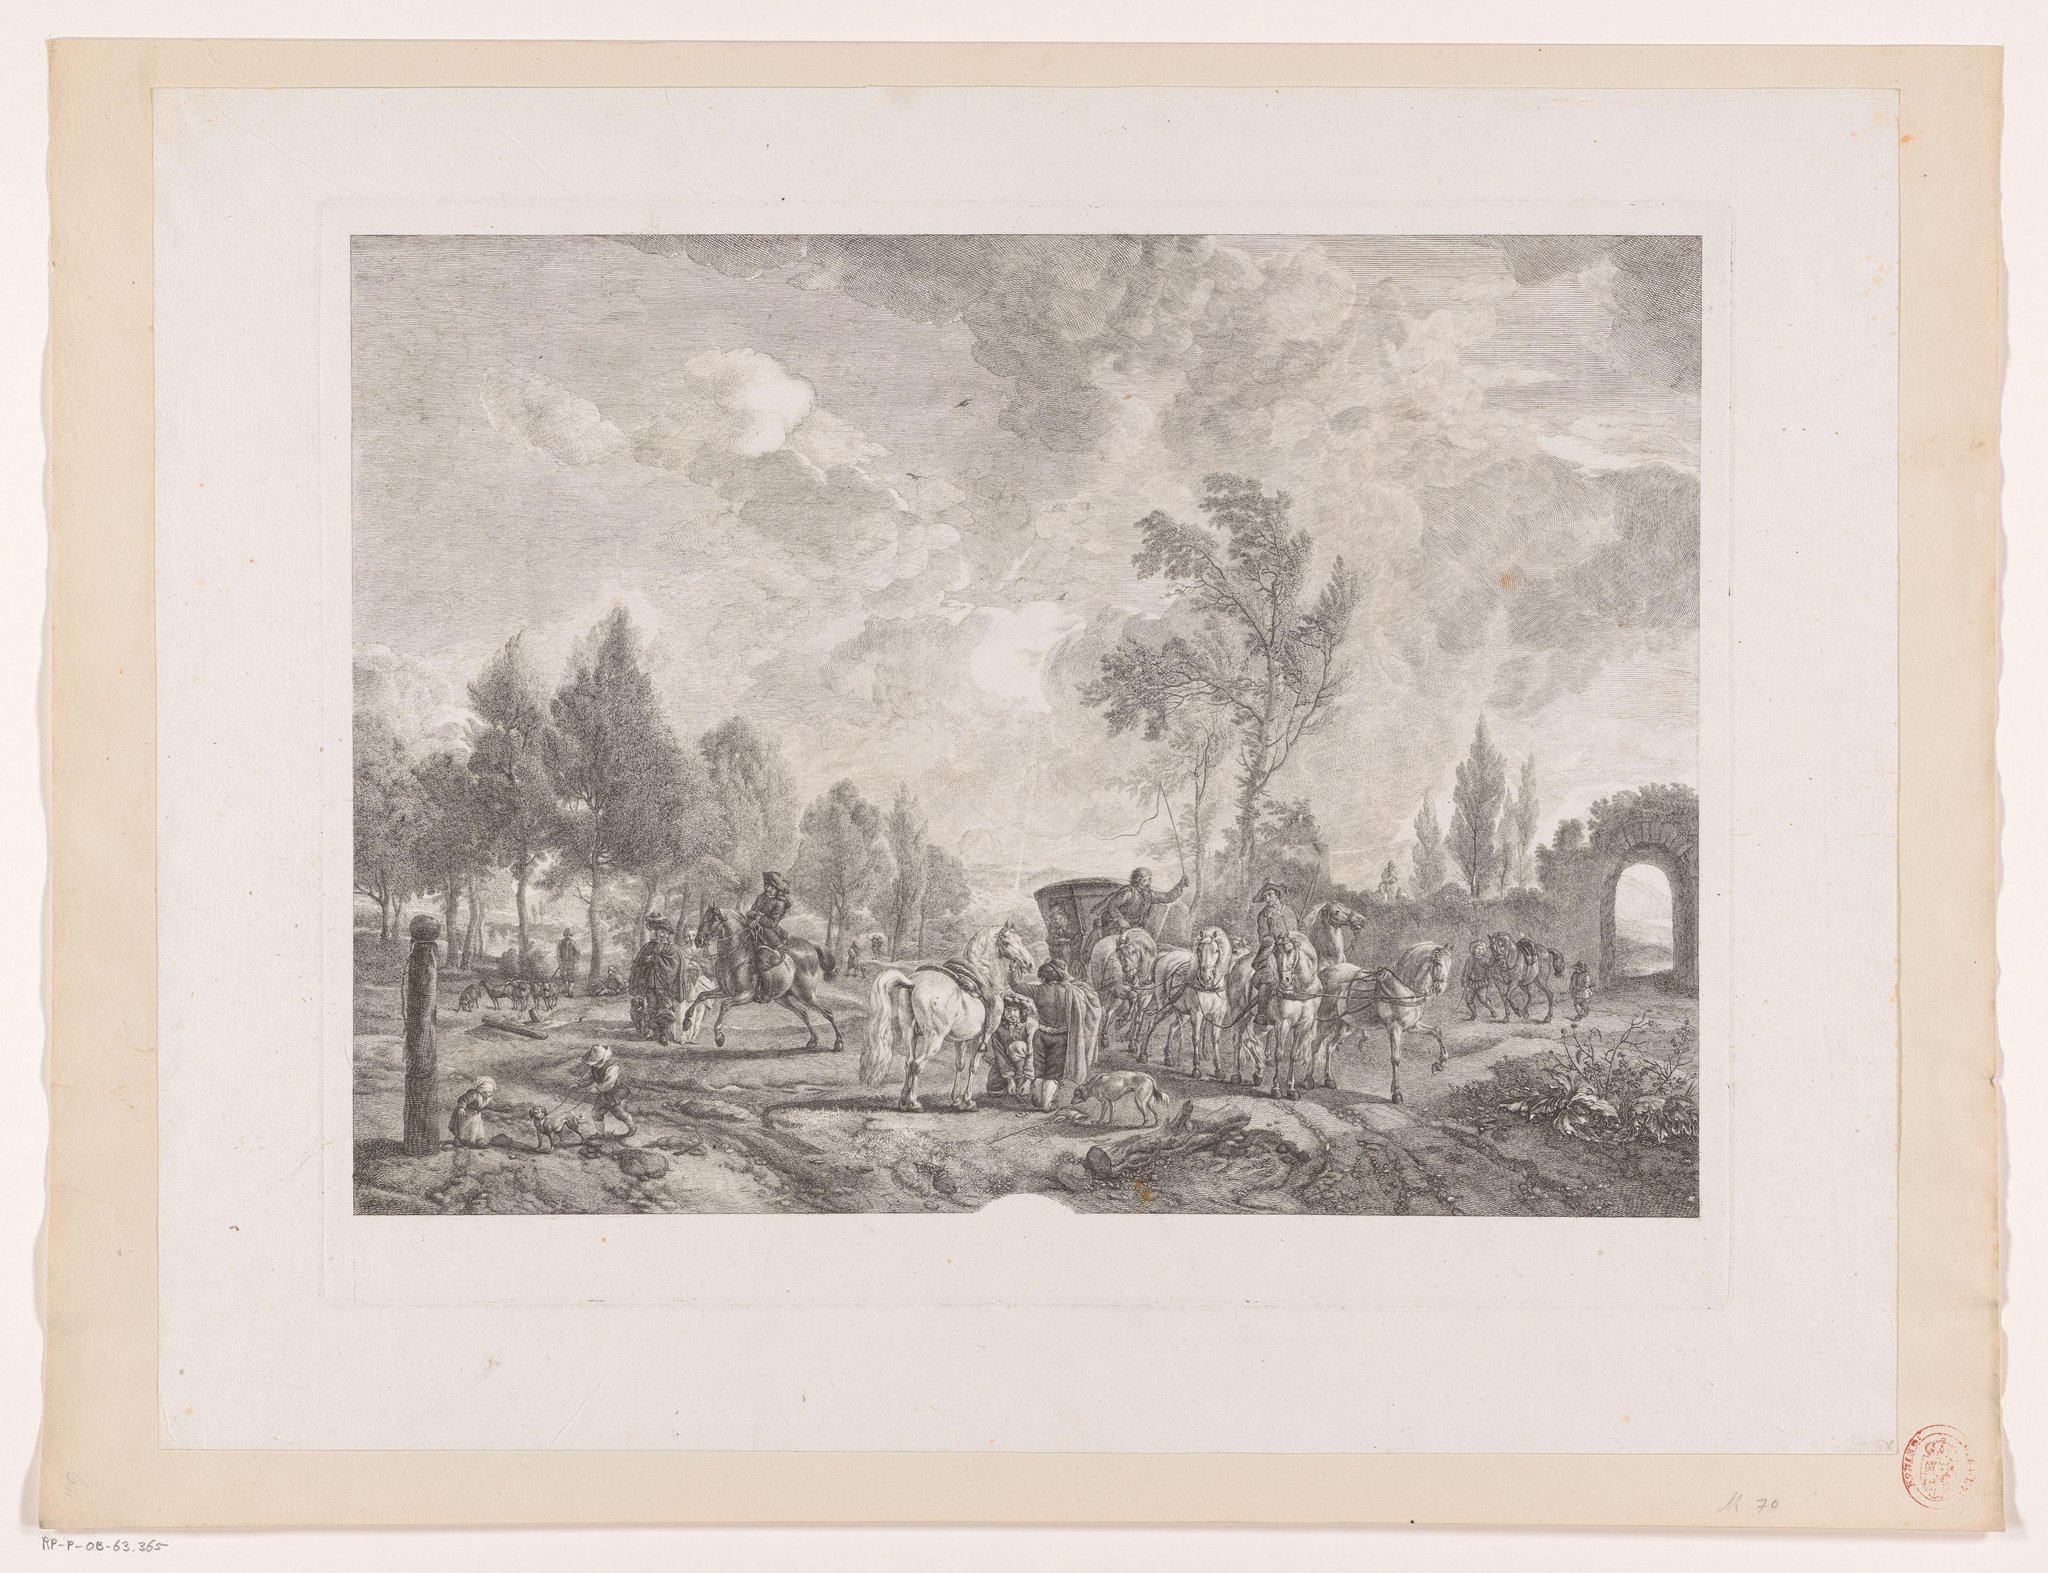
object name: print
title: Cavaliers du manège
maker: jean moyreau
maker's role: print maker, publisher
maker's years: 1690-1762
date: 1752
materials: paper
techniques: etching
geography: france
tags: riding a horse, ass, or mule; rider, horseman, passenger carriage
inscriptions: collector's mark: Lugt 240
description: Maakt deel uit van een serie van 89 prenten te dateren tussen ca. 1733-1762, naar het geschilderde oeuvre van Philips Wouwerman. Dit betreft plaat 70.